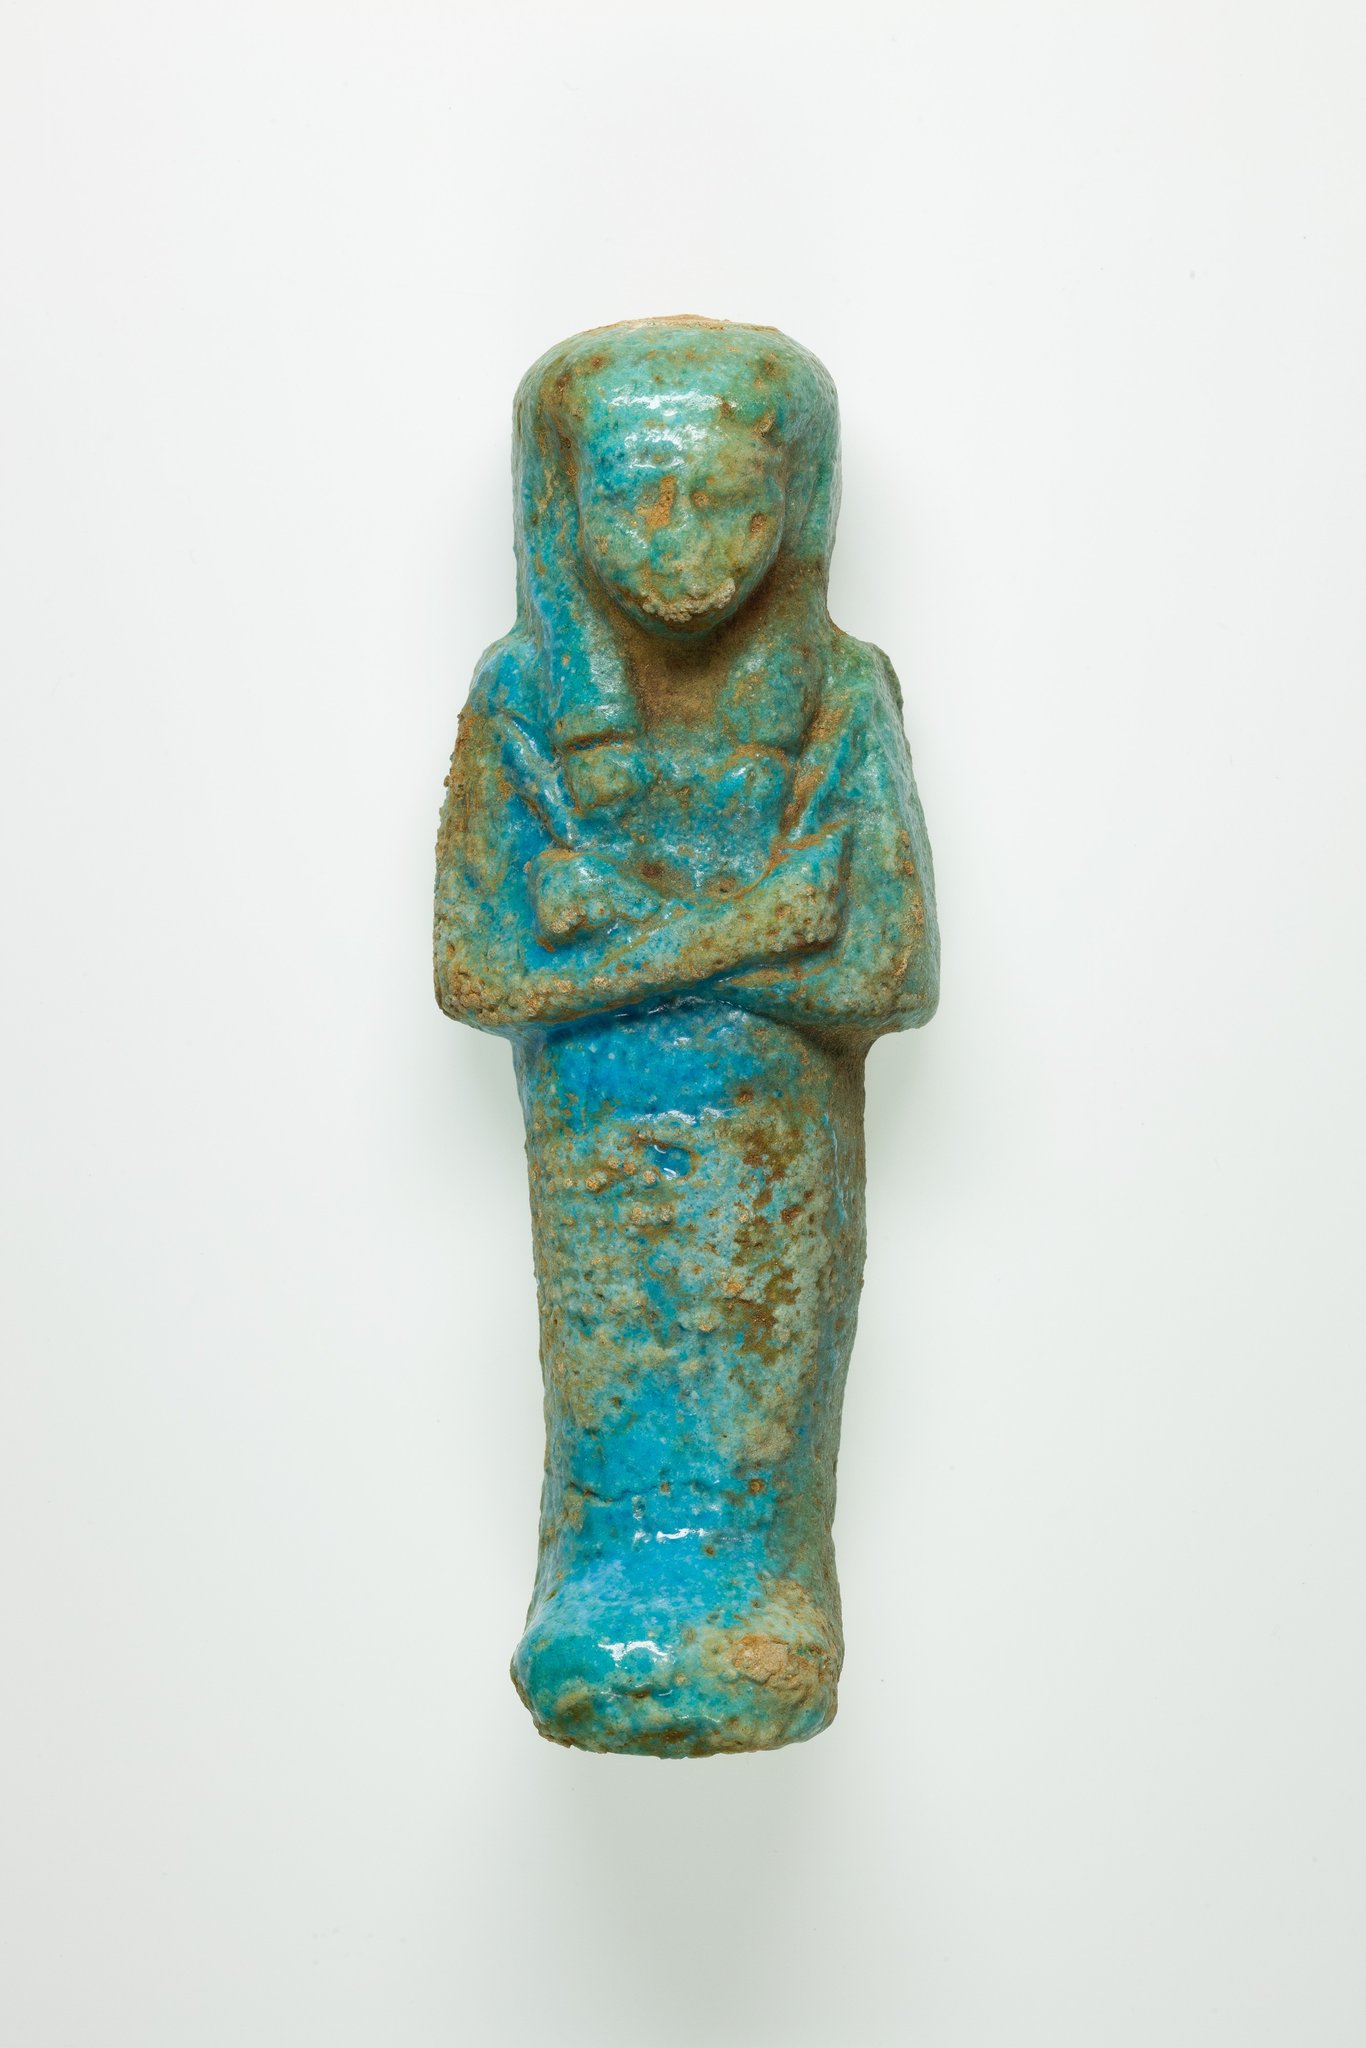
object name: worker shabti, henettawy c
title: Worker Shabti of Henettawy (C), Daughter of Isetemkheb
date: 990-970 BCE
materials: faience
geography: egypt